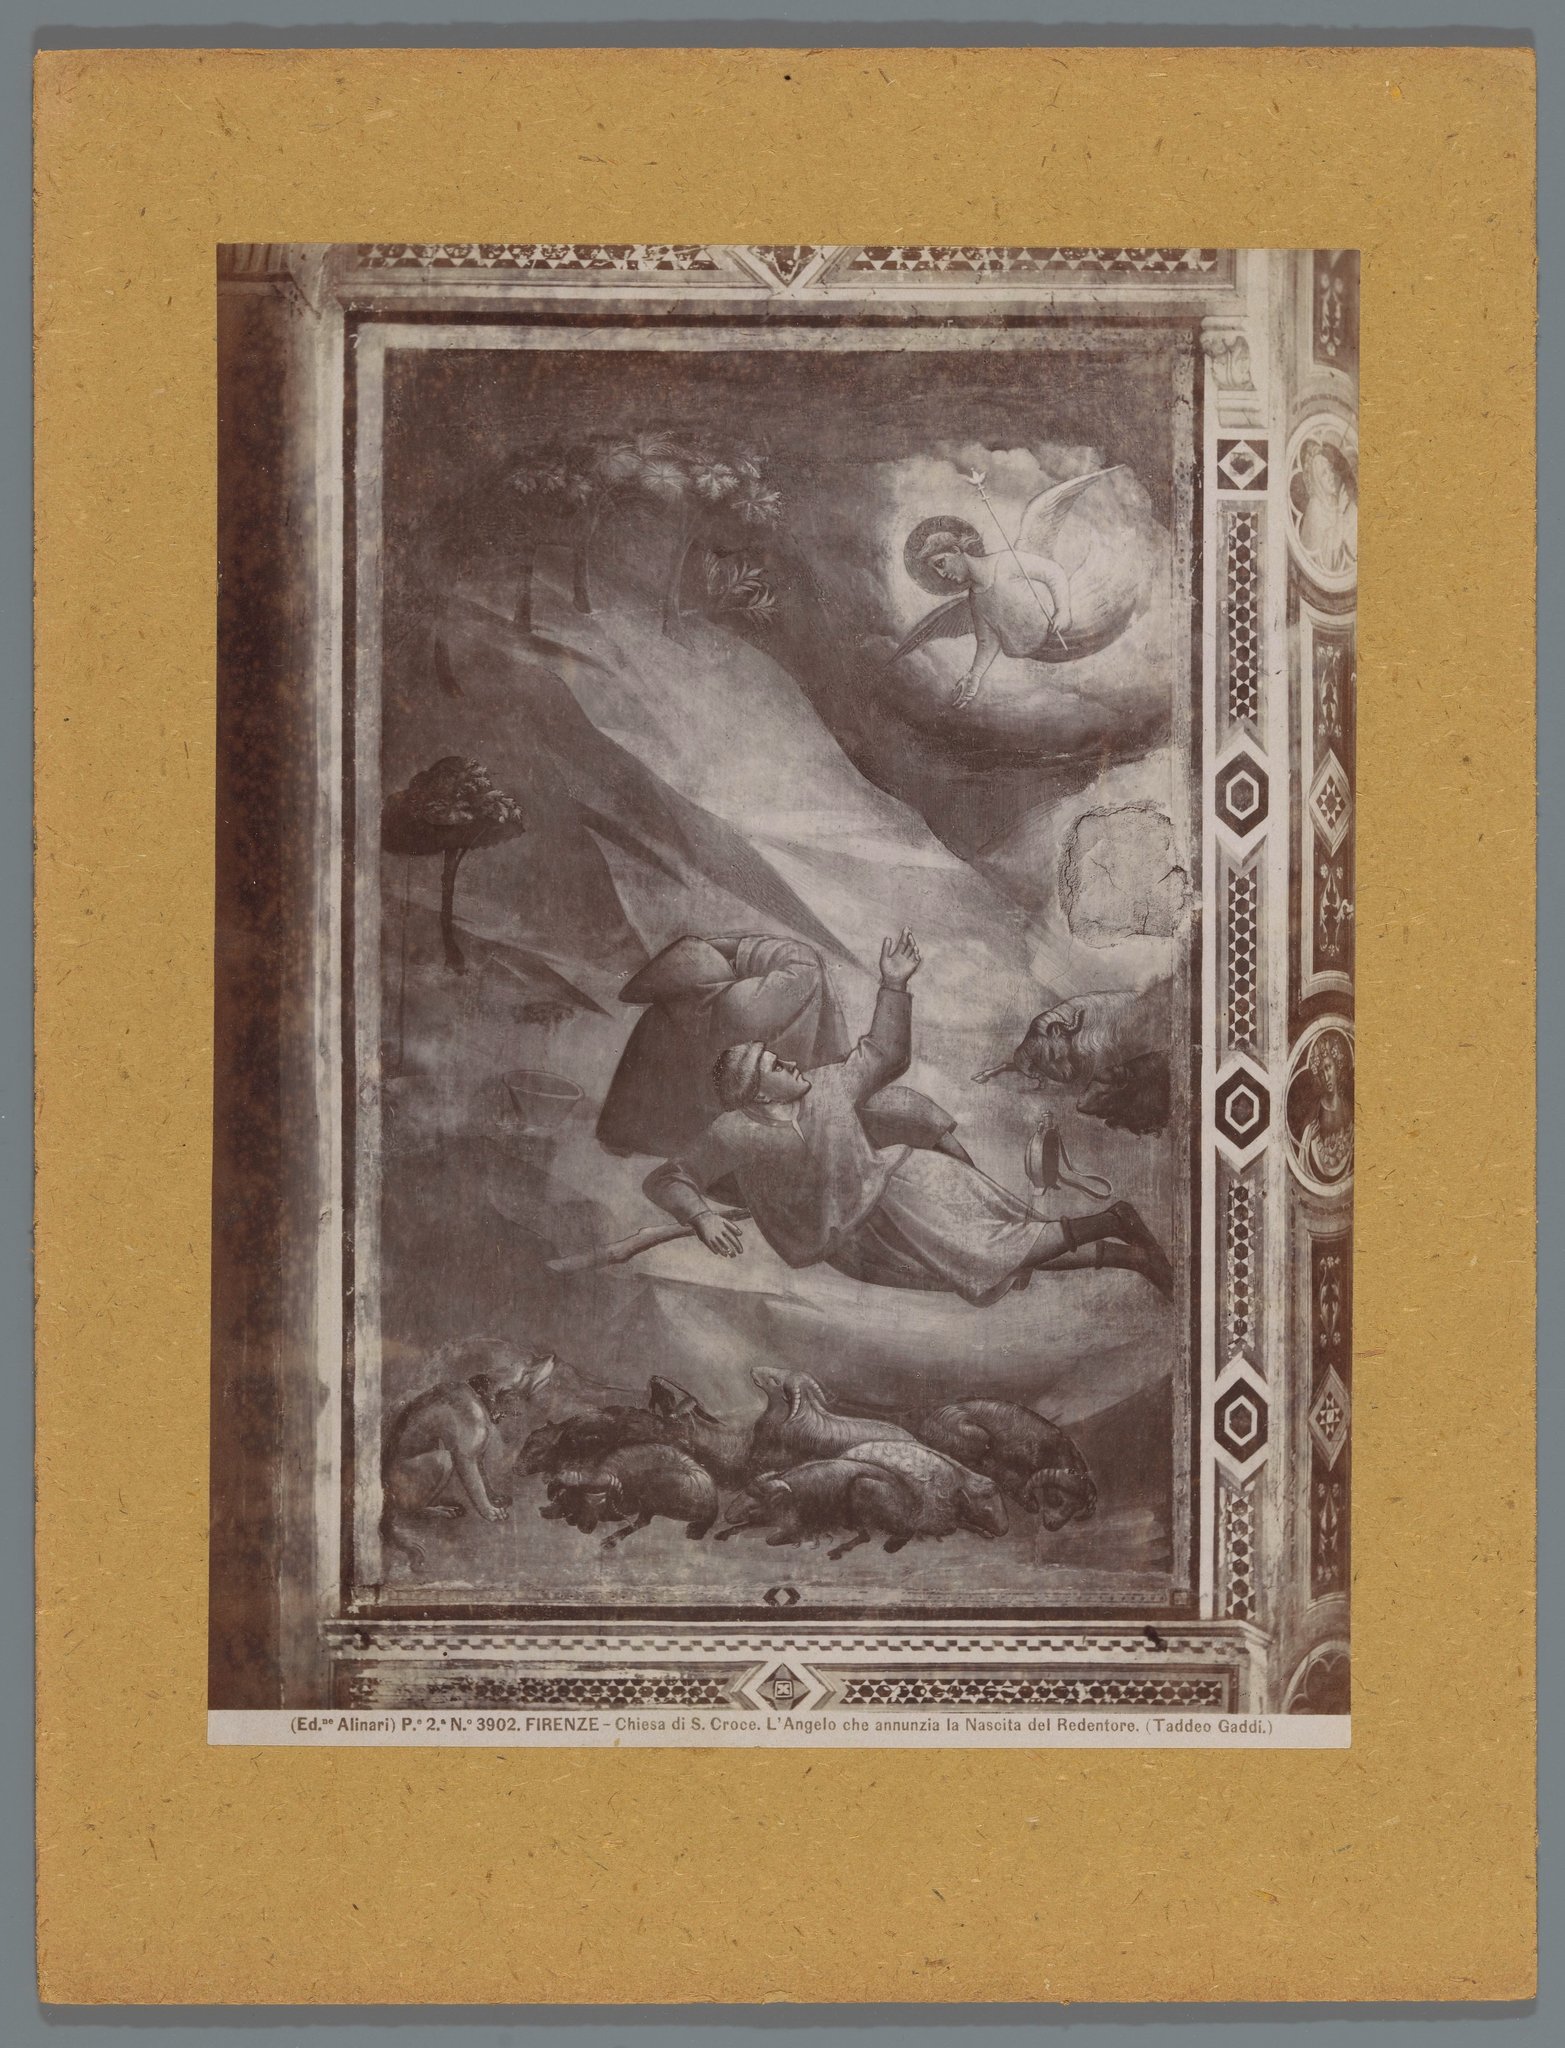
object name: photograph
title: FIRENZE - Chiesa di S. Croce. L'Angelo che annunzia la Nascita del Redentore.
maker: taddeo gaddi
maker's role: painter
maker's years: 1290-1366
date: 1875-1900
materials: cardboard, photographic support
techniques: albumen print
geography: florence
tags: annunciation of christ's birth to the shepherds (and/or shepherdesses) at night; a host of singing angels in the air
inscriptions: collector's mark: Lugt 3937, number: ‘P. 2. N. 3902.’